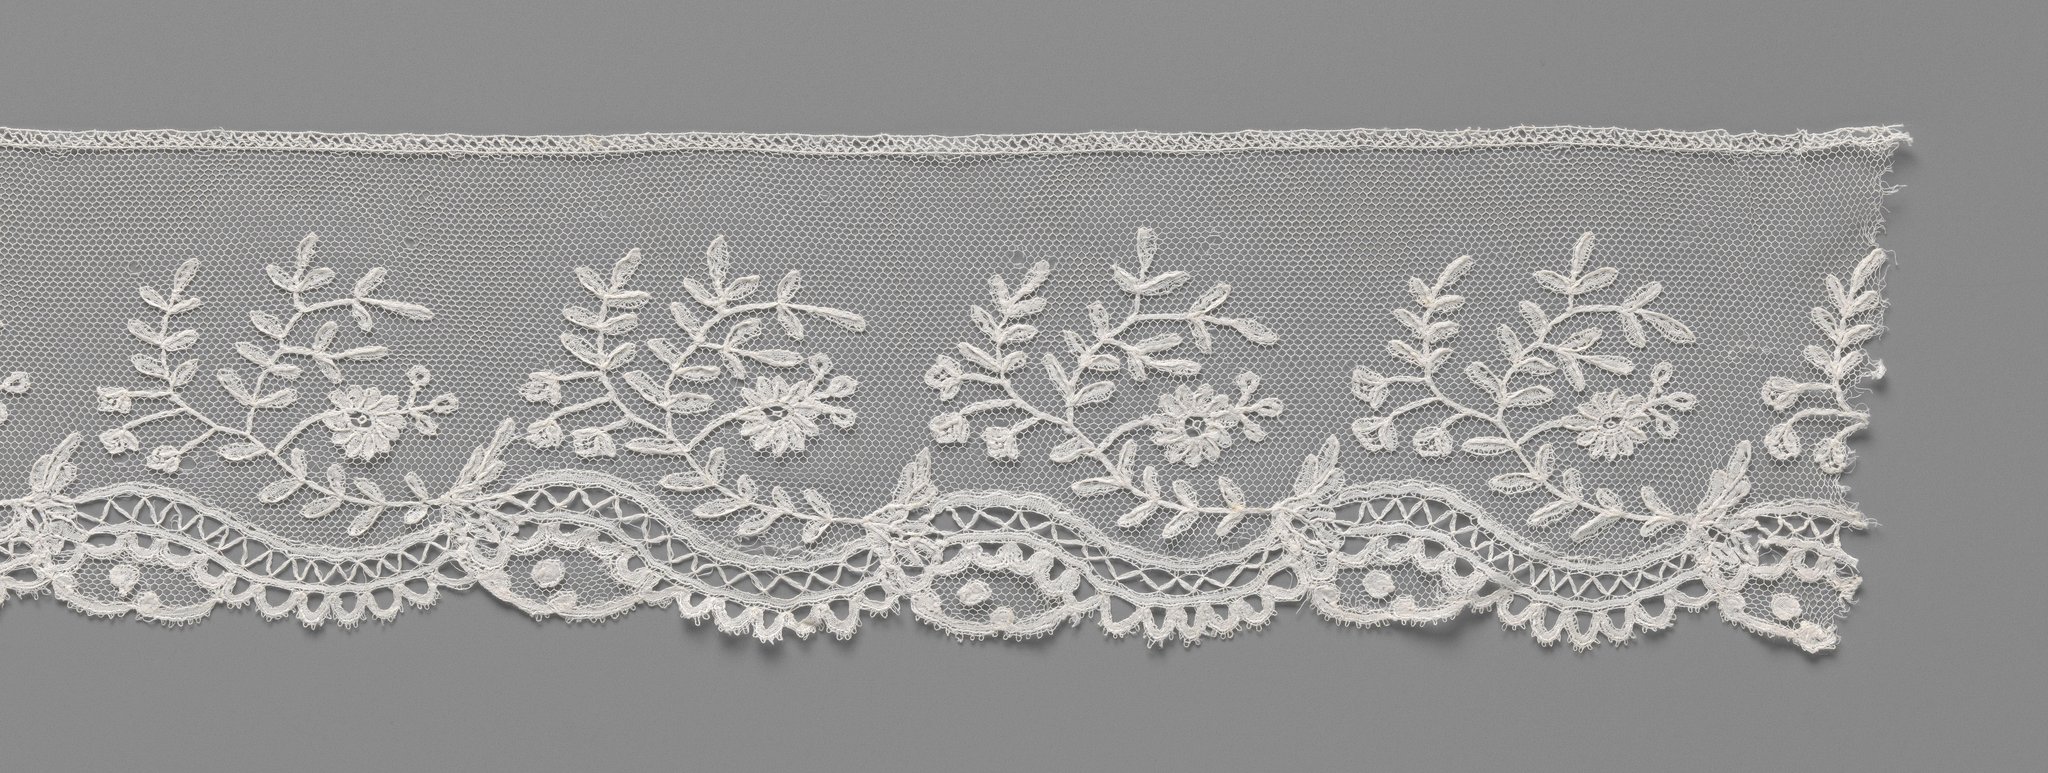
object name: strip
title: Strook applicatiekant met c-vormige bloemtak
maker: Anonymous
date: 1850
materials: cotton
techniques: lace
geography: brussels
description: Strook naturelkleurige Brusselse applicatiekant: kloskant met enkele naaldkantsiersteken geappliceerd op machinale tule. Het zich herhalende patroon bestaat uit c-vormige bloemtakken, die ontspringen uit een golvende onderrand met zigzagpatroon. Deze rand is afgezet met gepicoteerde boogjes, met onder elke golftop een rocaille-achtig motief met een stip in het centrum. De motieven zijn gemaakt in linnenslag met opengewerkte randjes en voorzien van reliëfcontouren. De bovenzijde is afgezet met een apart geklost bandje.